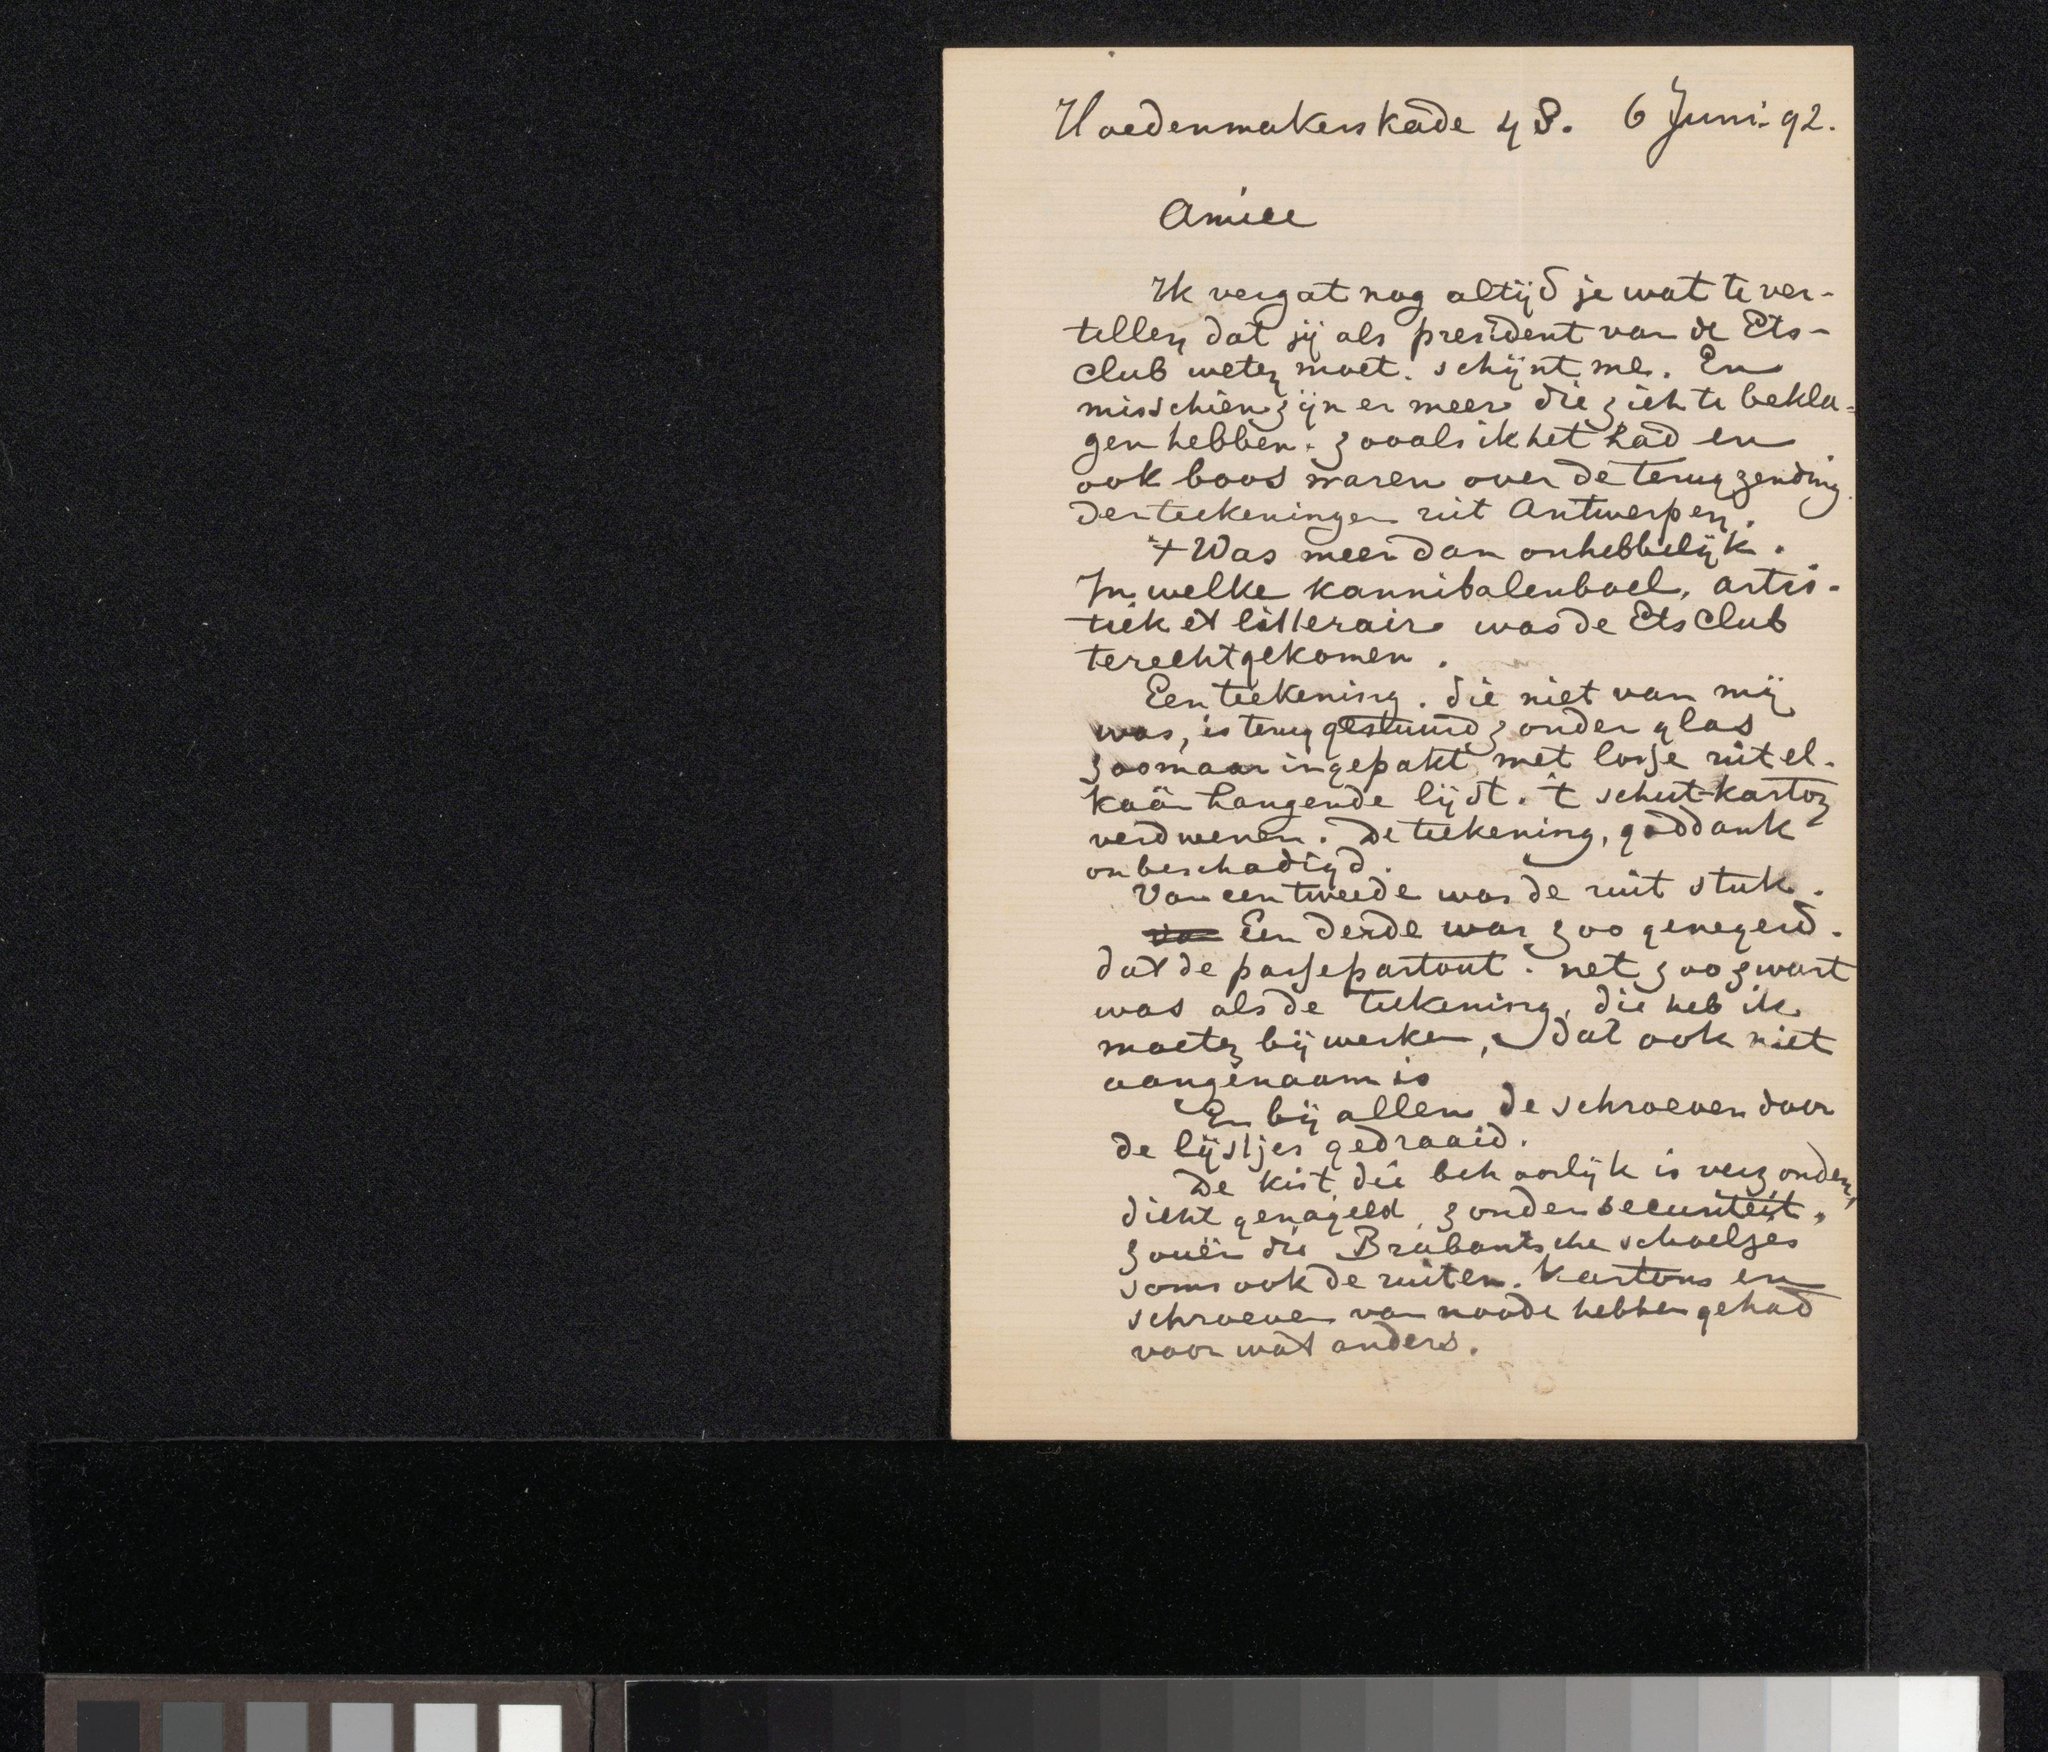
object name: letter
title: Brief aan Jan Veth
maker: jac van looij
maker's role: draughtsman, painter, print maker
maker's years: 1855-1930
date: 1892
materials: ink, paper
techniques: pen, writing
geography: amsterdam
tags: dordrecht, painter, jan veth, drawing, exhibition ~ art, antwerp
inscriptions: collector's mark: ‘RPK’